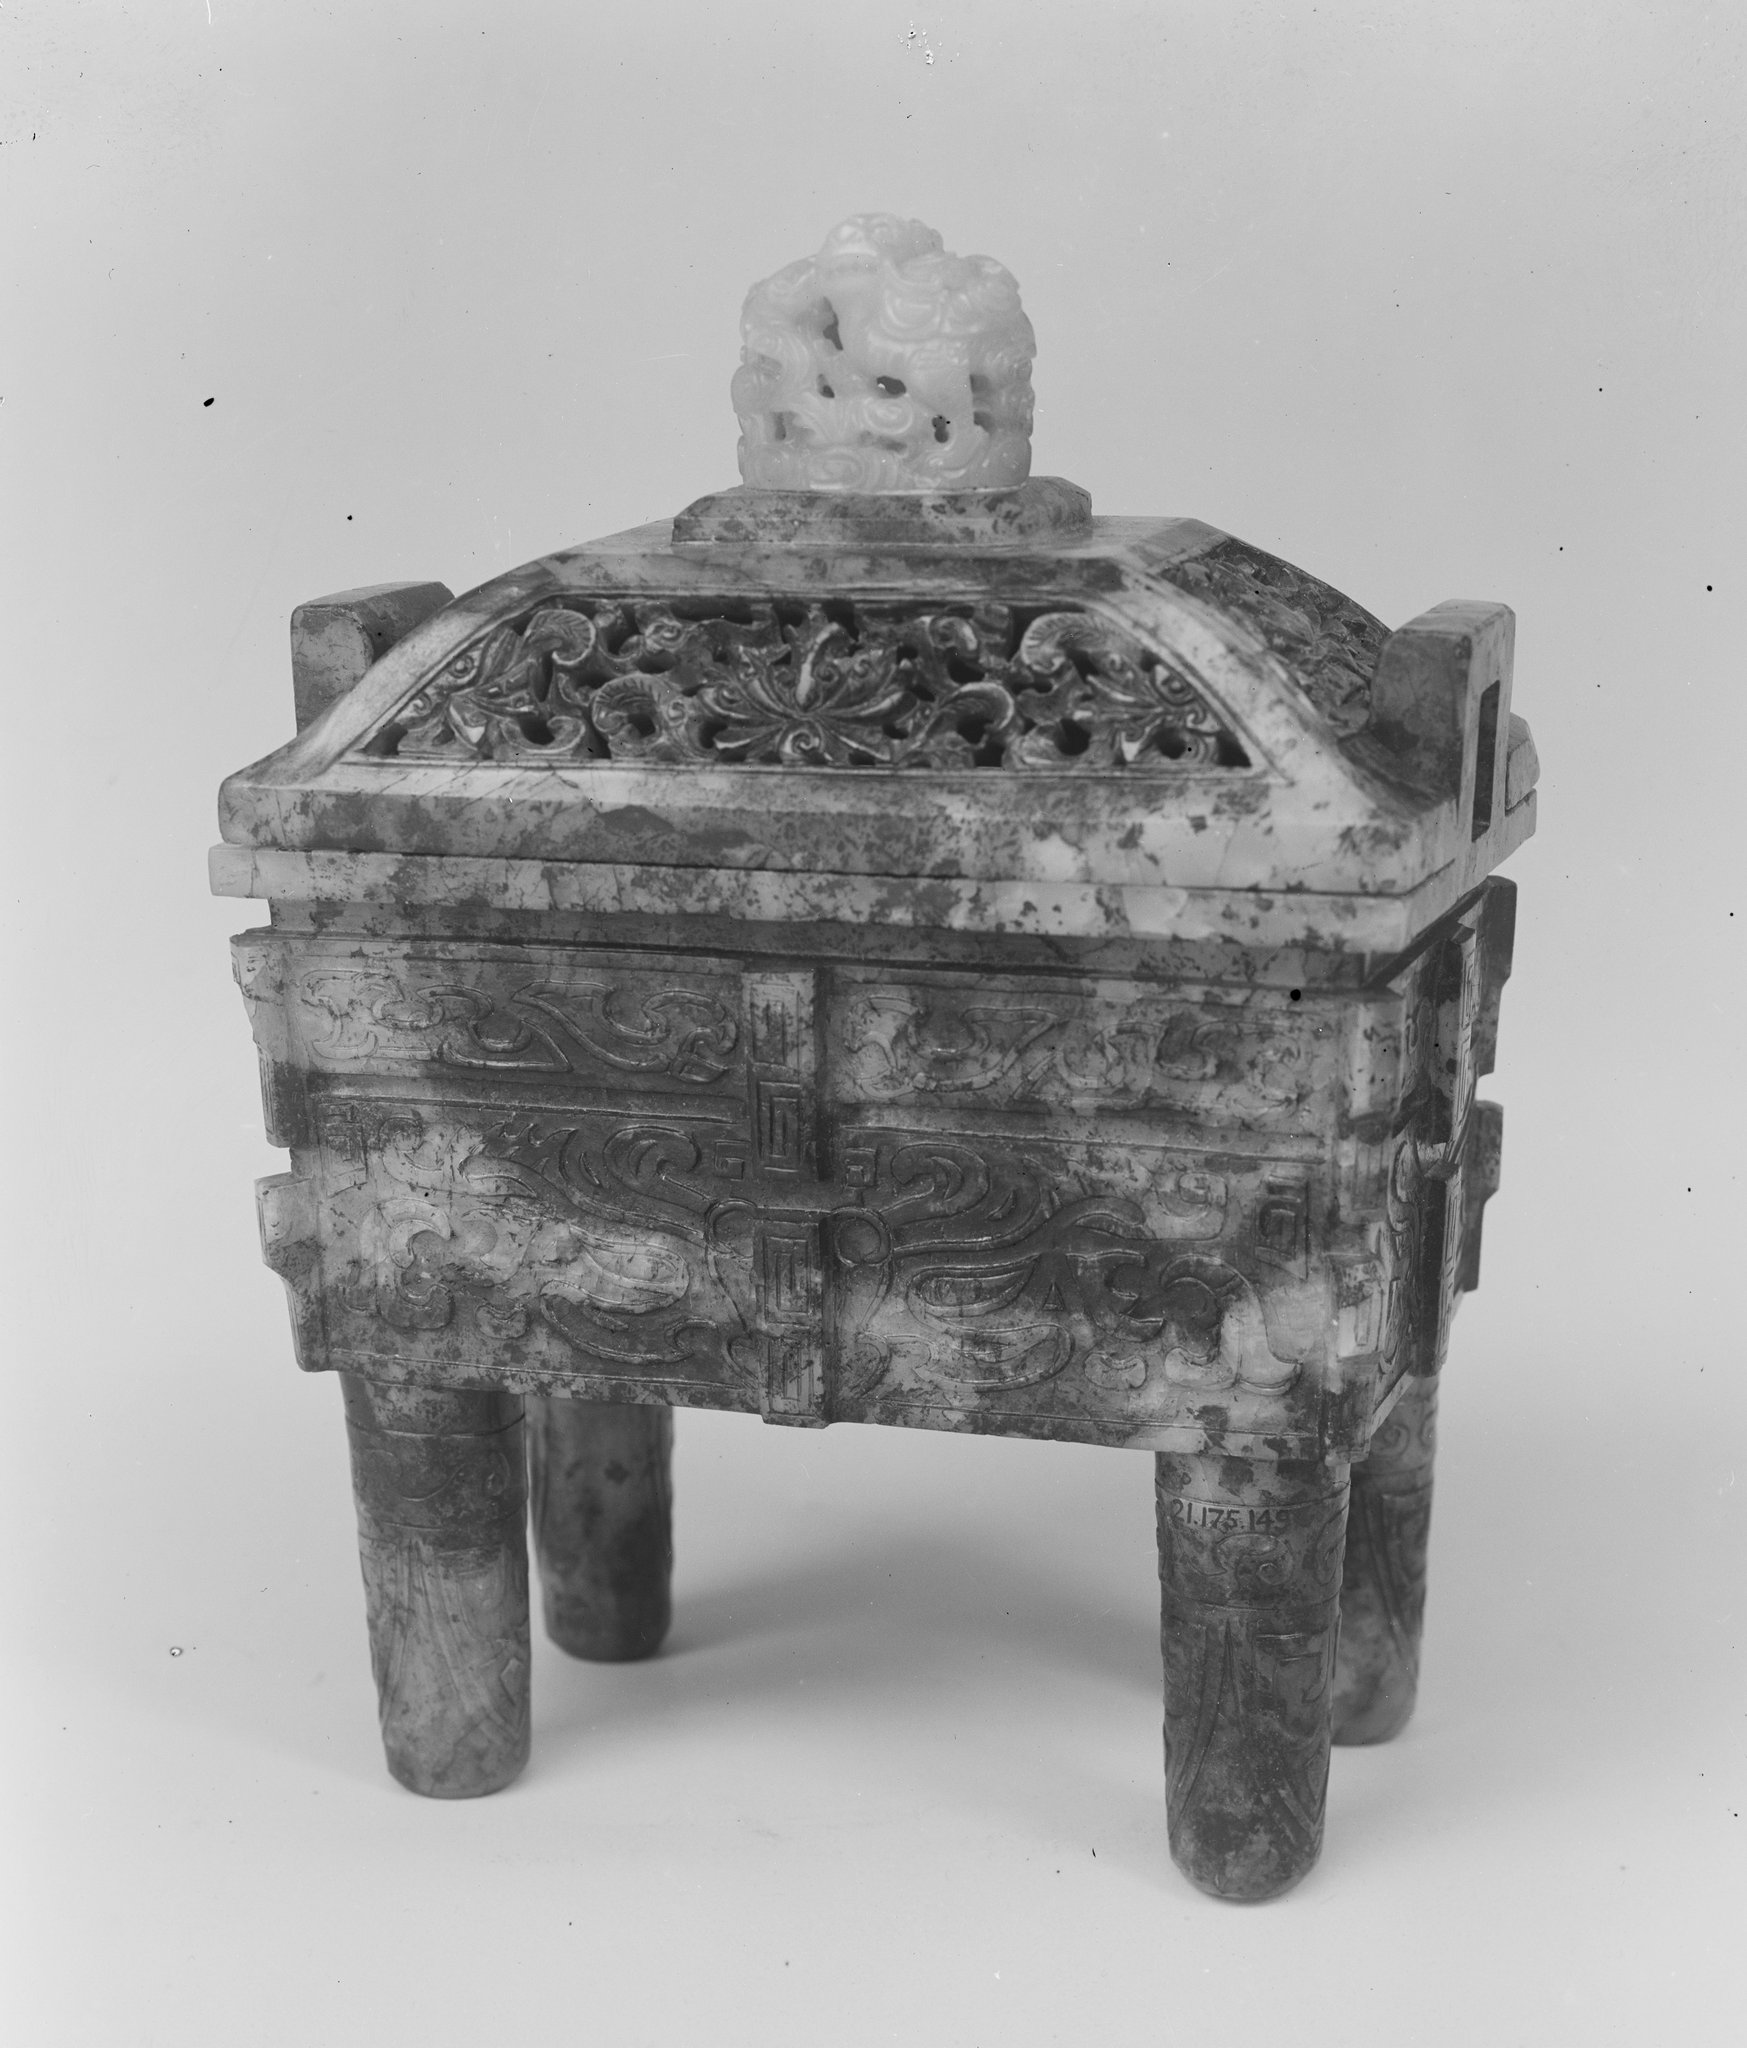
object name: incense burner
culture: chinese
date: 1736-1795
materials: jade